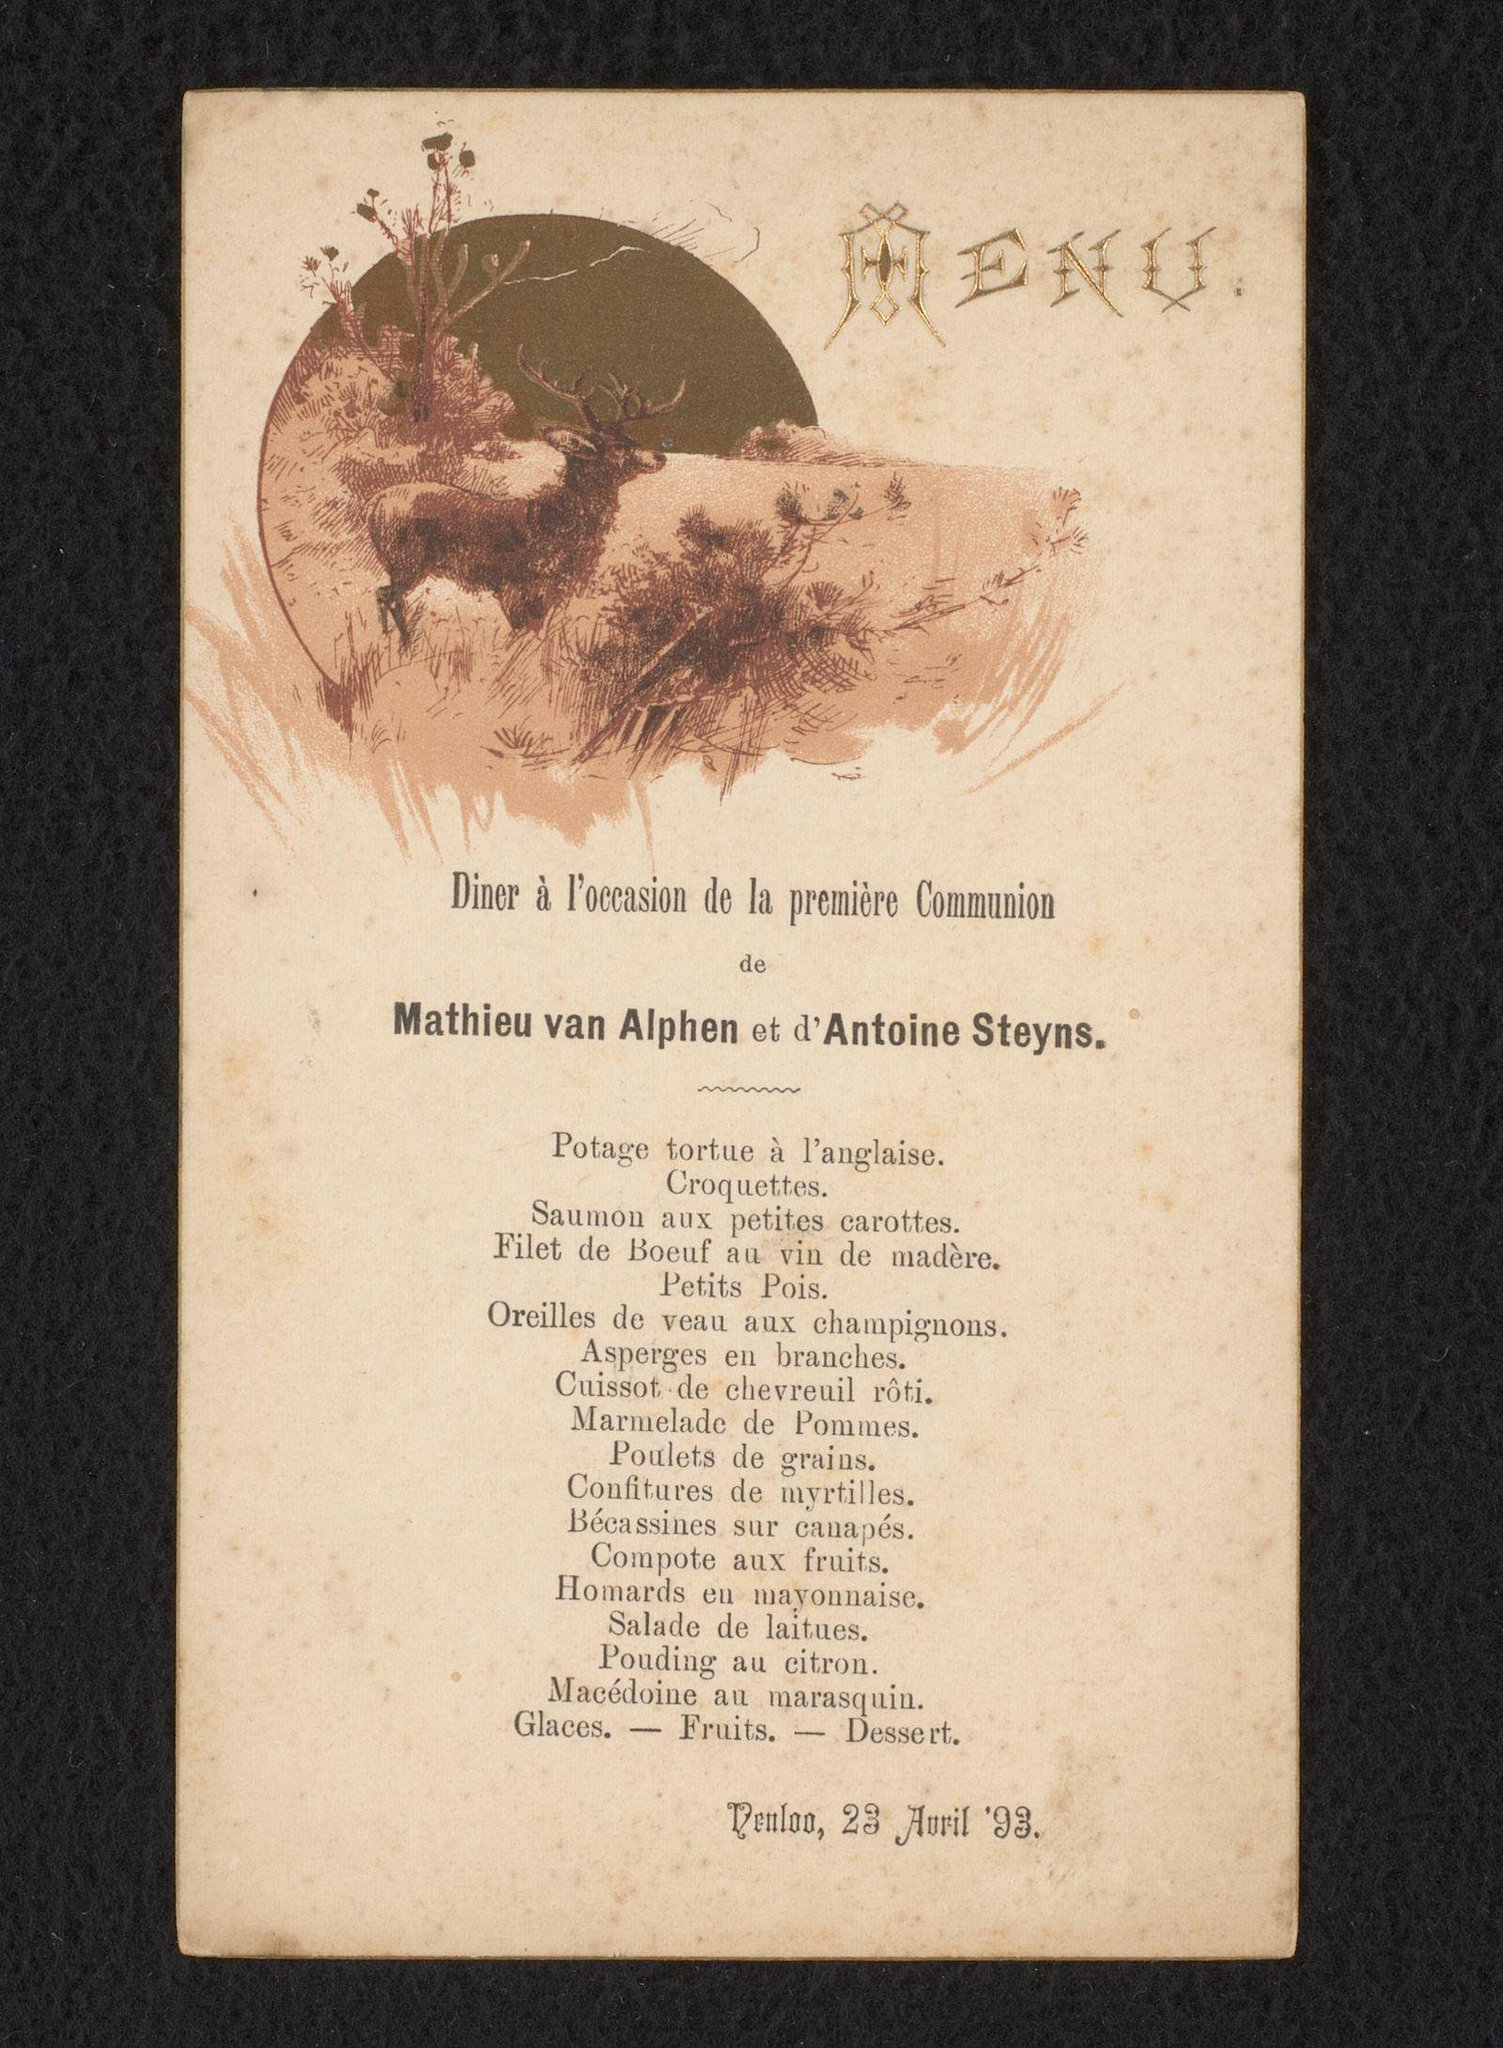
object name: menu, menukaart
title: Menu van het diner ter ere van de eerste heilige communie van Mathieu van Alphen en Antoine Steyns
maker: Anonymous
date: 1893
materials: paper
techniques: lithograph, letterpress printing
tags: hoofed animals: deer, first communion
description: Bij gebrek aan gegevens over de vervaardiger is voor de bepaling van de rechten van dit object gebruik gemaakt van de vervaardigingsdatum.